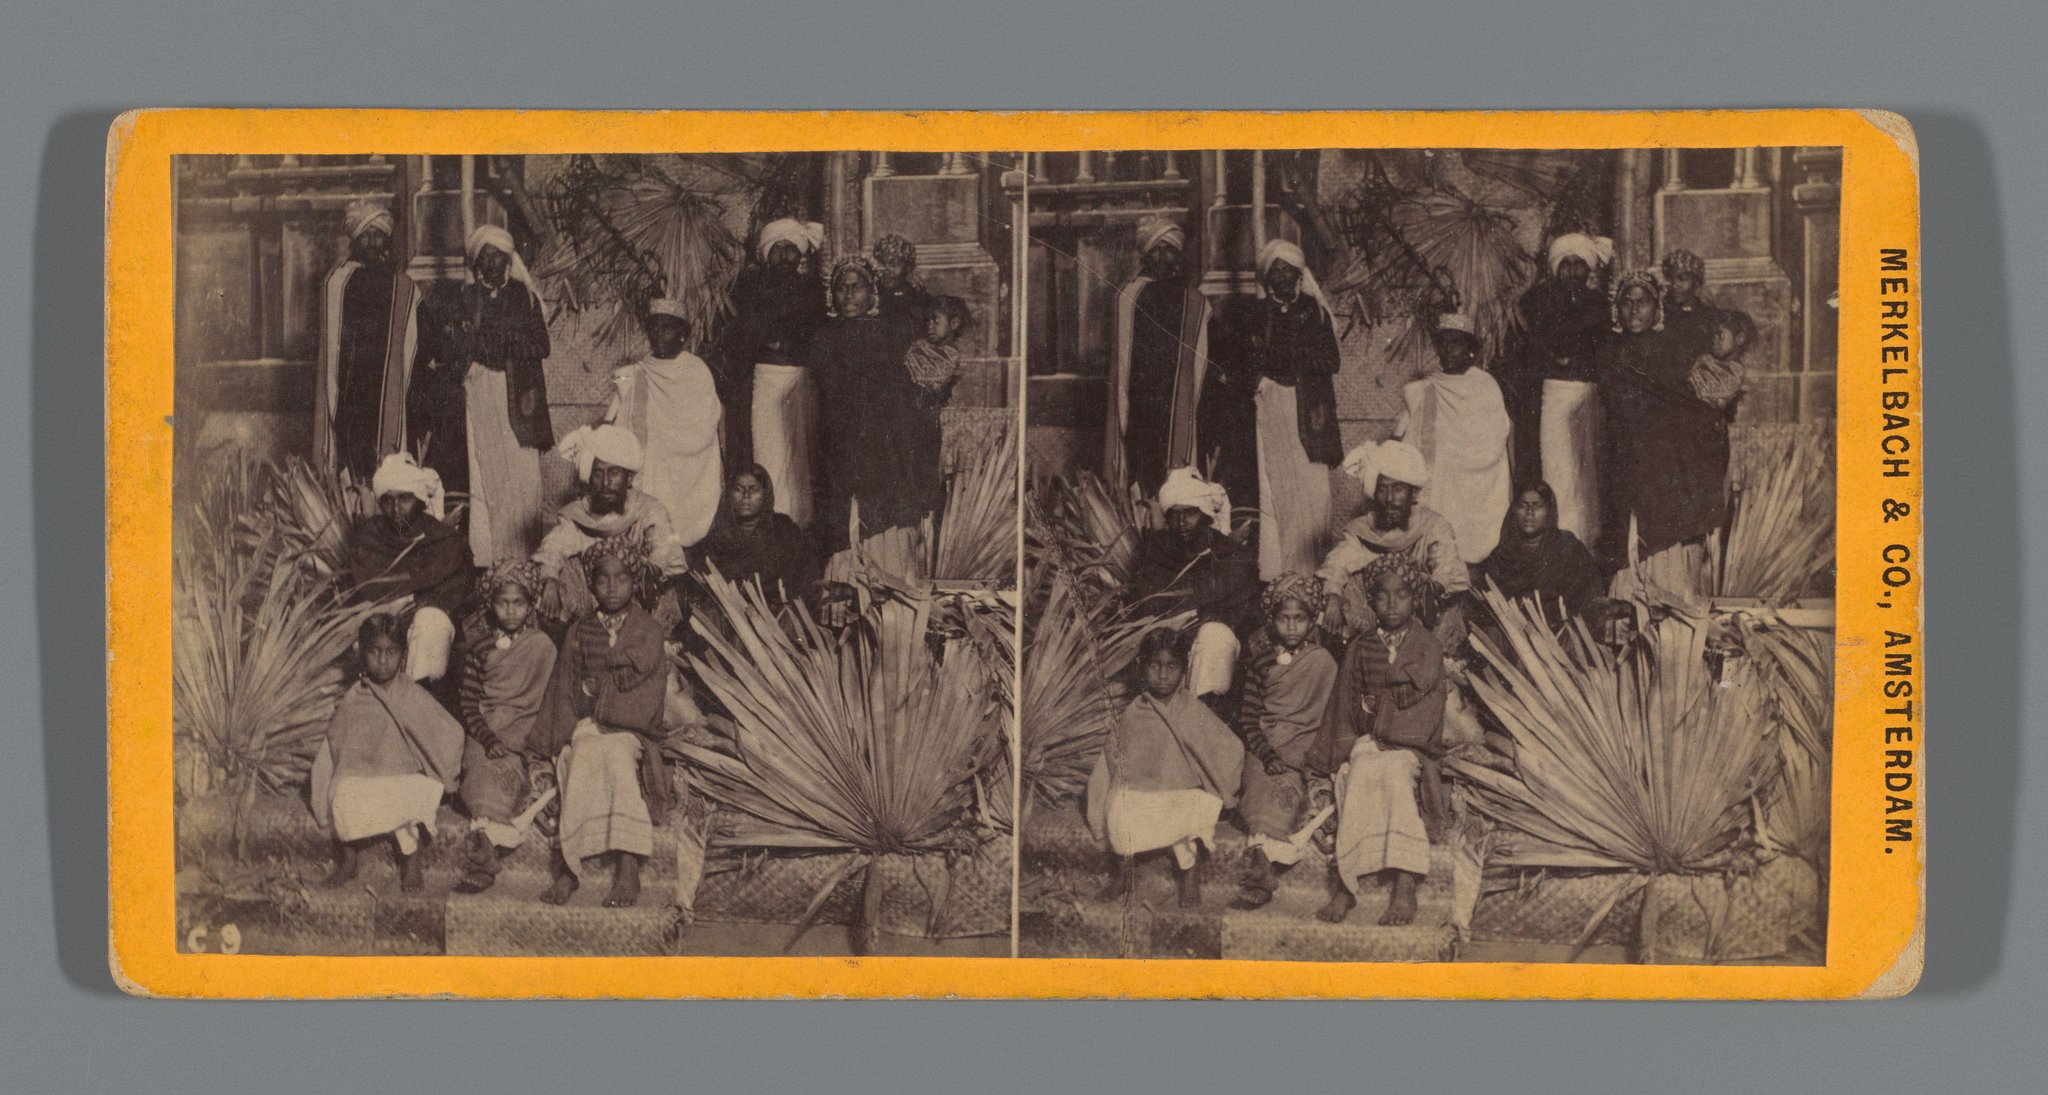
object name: stereograph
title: Aardrijkskundige Beeldengalerij, verzameld door M.J. Broekhuijsen, Hoofd eener school te Amsterdam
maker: martien johan broekhuijsen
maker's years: 1871-1956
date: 1905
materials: photographic support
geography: amsterdam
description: Onderdeel van een groep van 52 stereofoto's gebruikt in het lager onderwijs als aanvulling op schoolplaten. De gehele reeks bestond uit 274 nummers in 10 categorieën (A t/m K).